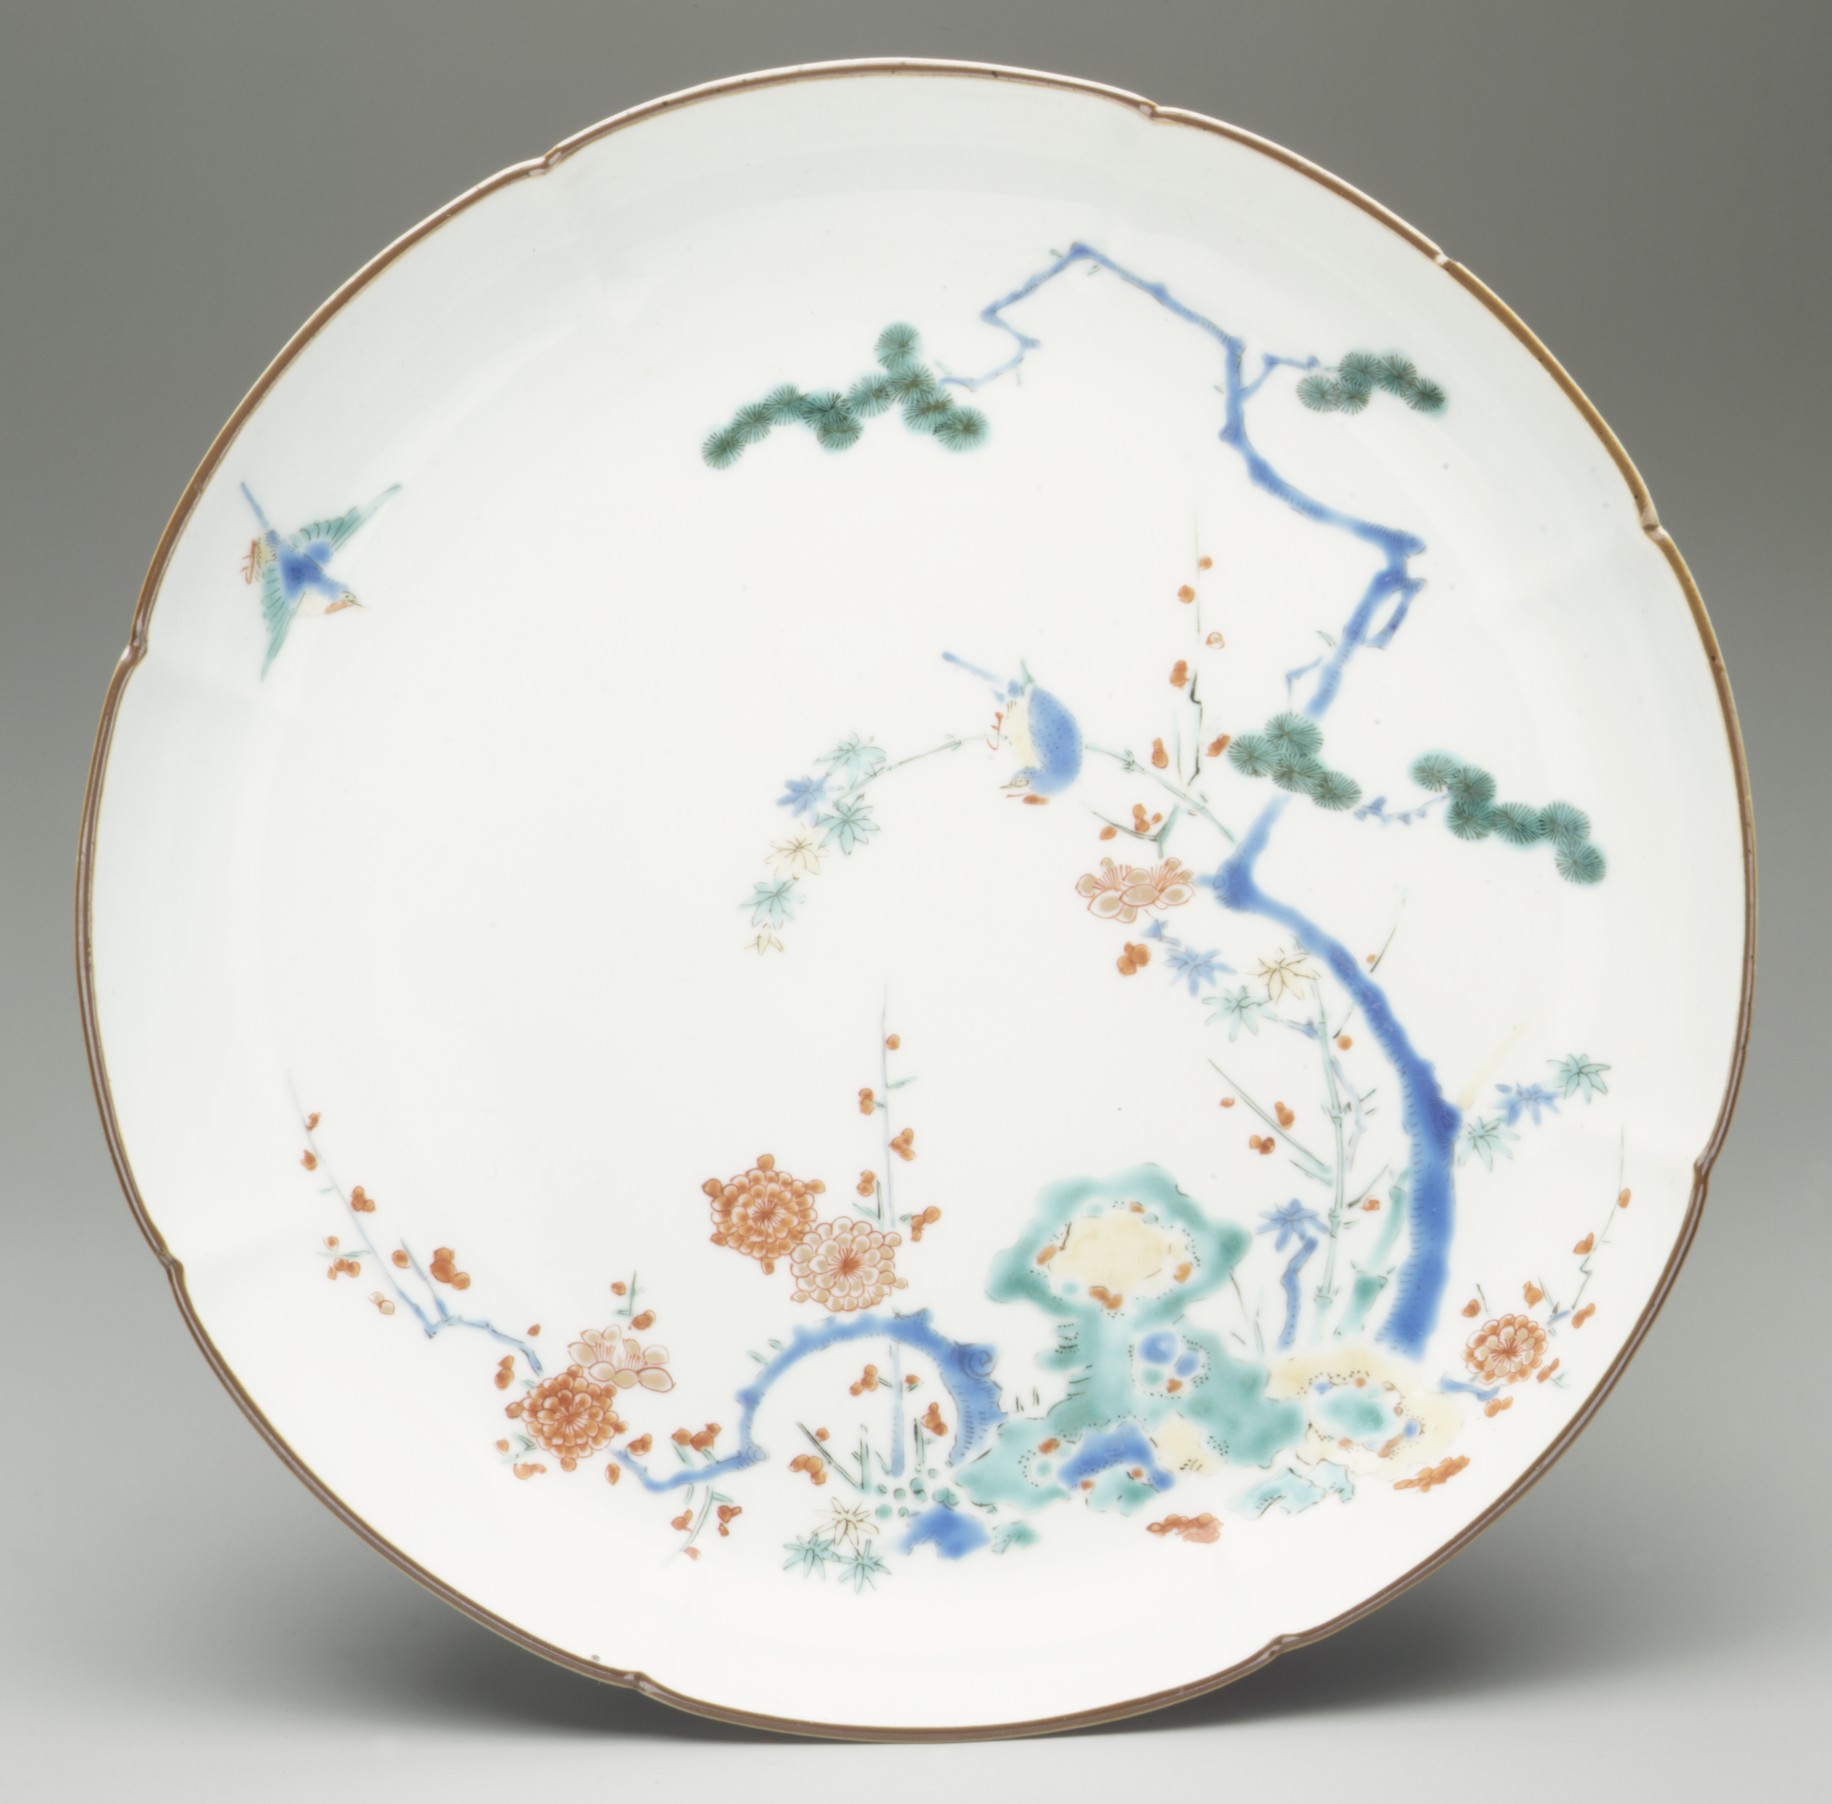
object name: dish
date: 1700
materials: hard paste porcelain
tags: birds,flowers,trees